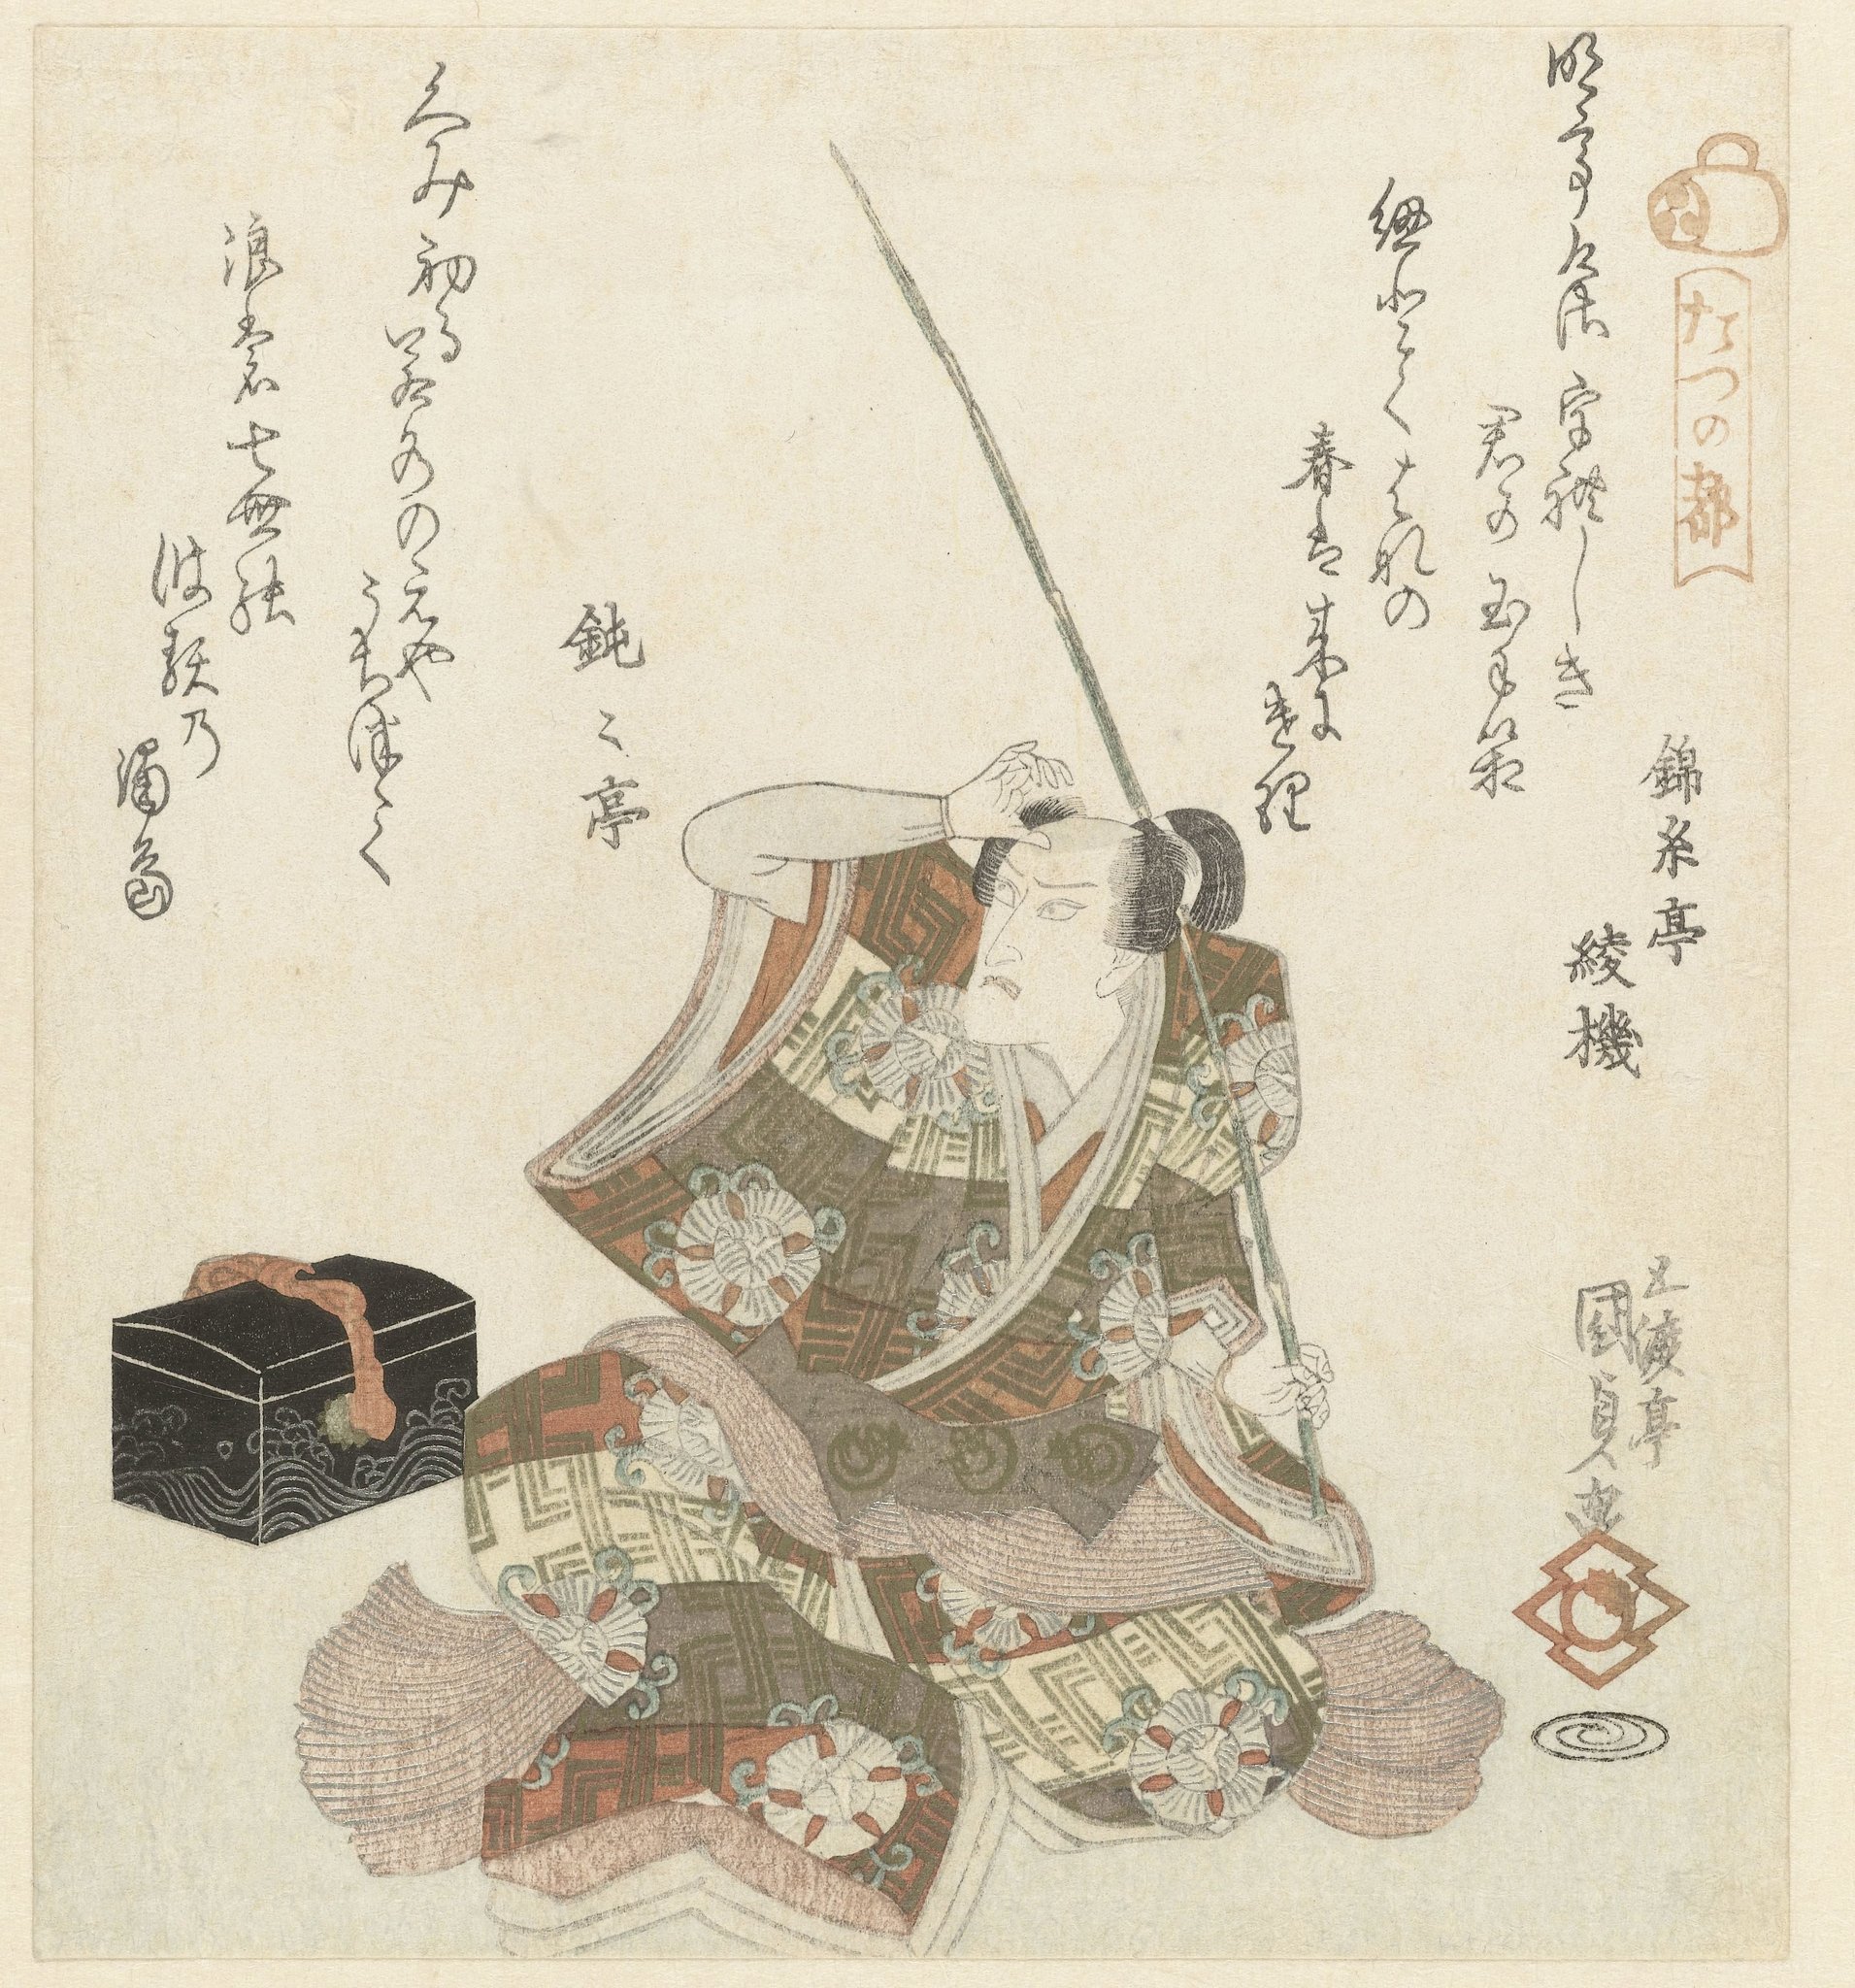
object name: surimono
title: Seated Man With Fishing Rod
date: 1820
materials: paper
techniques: woodcut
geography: japan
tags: sitting on the ground, angling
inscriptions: collector's mark, recto, stamped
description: Een man met een hengel tegen zijn schouder, kijkt in de verte. Naast hem staat een zwarte lak doos die met een rood koord is dichtgebonden. De man is acteur Ichikawa Danjûrô VII (1791-1859) in de rol van de jonge visser Urashimatarô uit een onbekend toneelstuk. Het Draken-capitool uit de serietitel refereert aan het paleis van de Draken-koning op de zeebodem, waar Urashimatarô mee naartoe wordt genomen door één van de prinsessen. Bij terugkomst blijken er honderden jaren verstreken te zijn. Met twee gedichten.